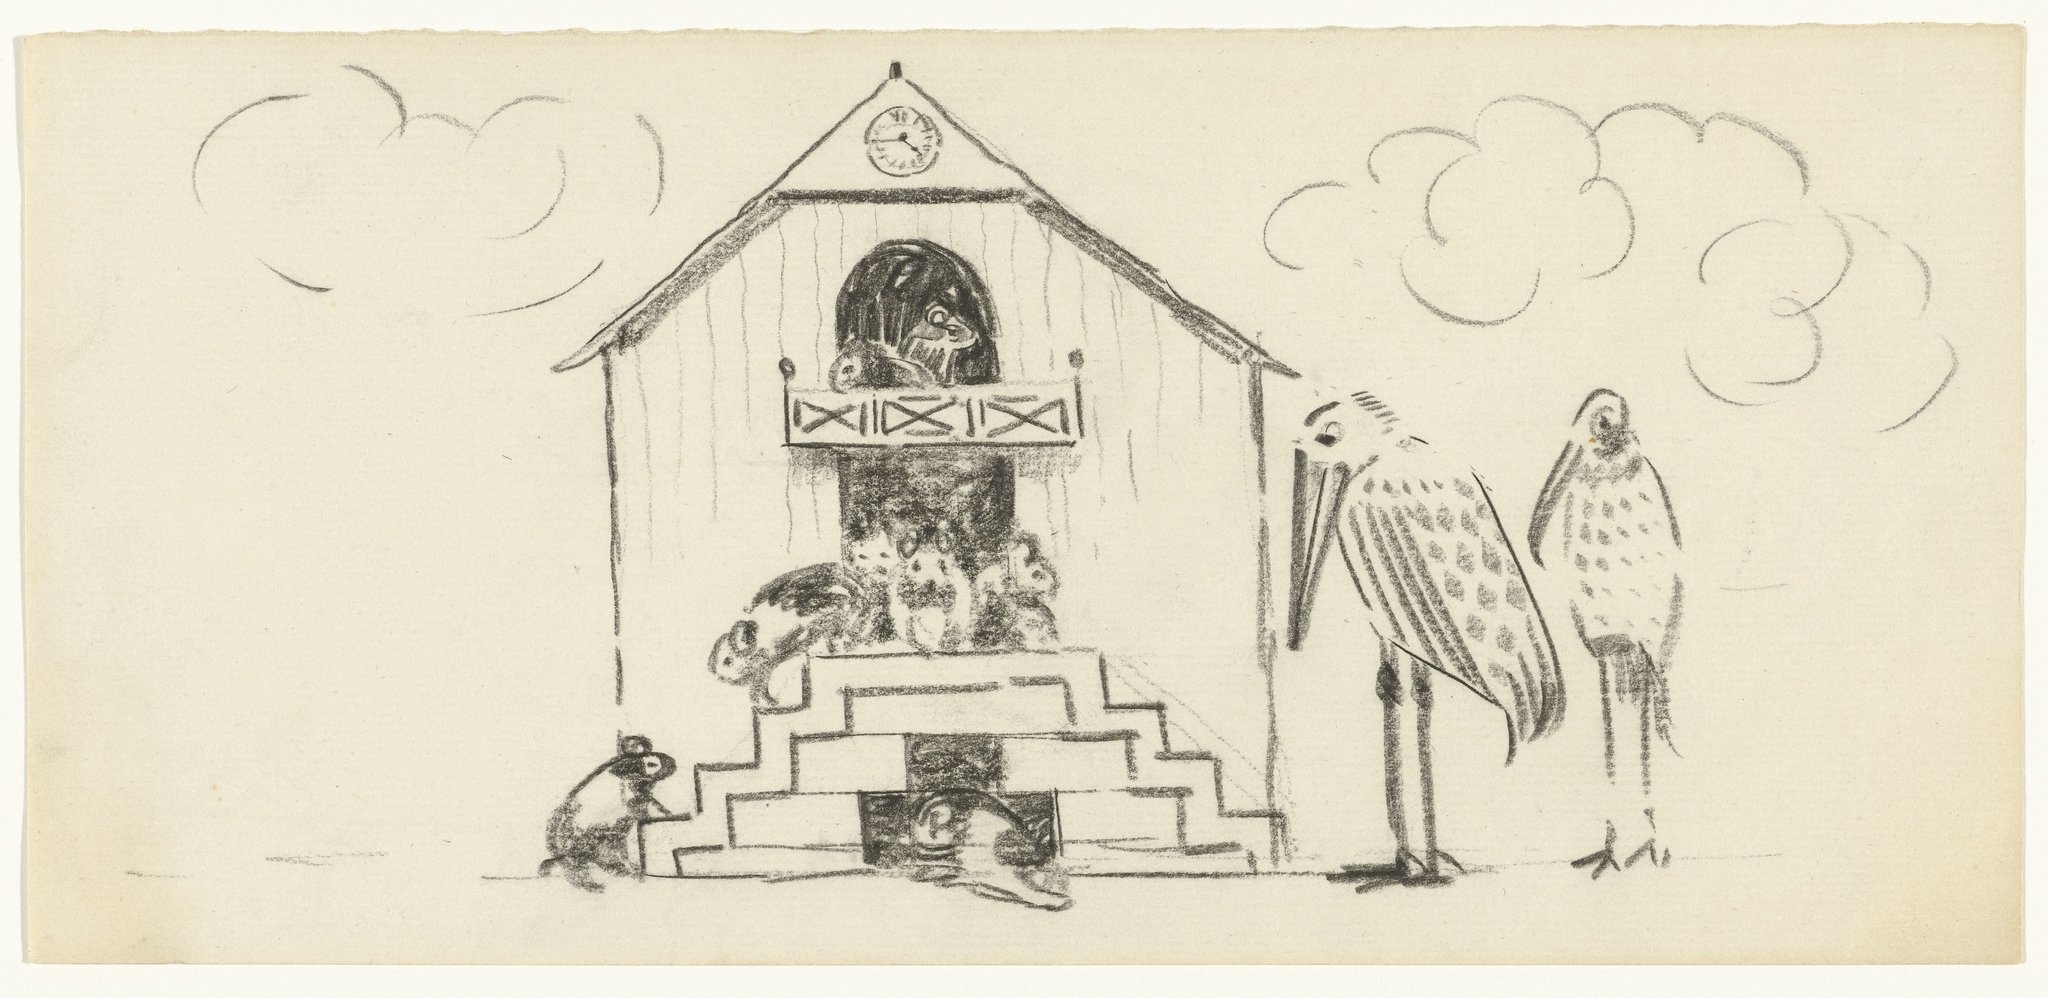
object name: drawing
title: Marmottenhuisje en twee ooievaars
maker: gerrit willem dijsselhof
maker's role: designer, draughtsman, print maker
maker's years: 1866-1924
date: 1876-1924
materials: chalk, paper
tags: shore-birds and wading-birds: stork, rodents: guinea pig